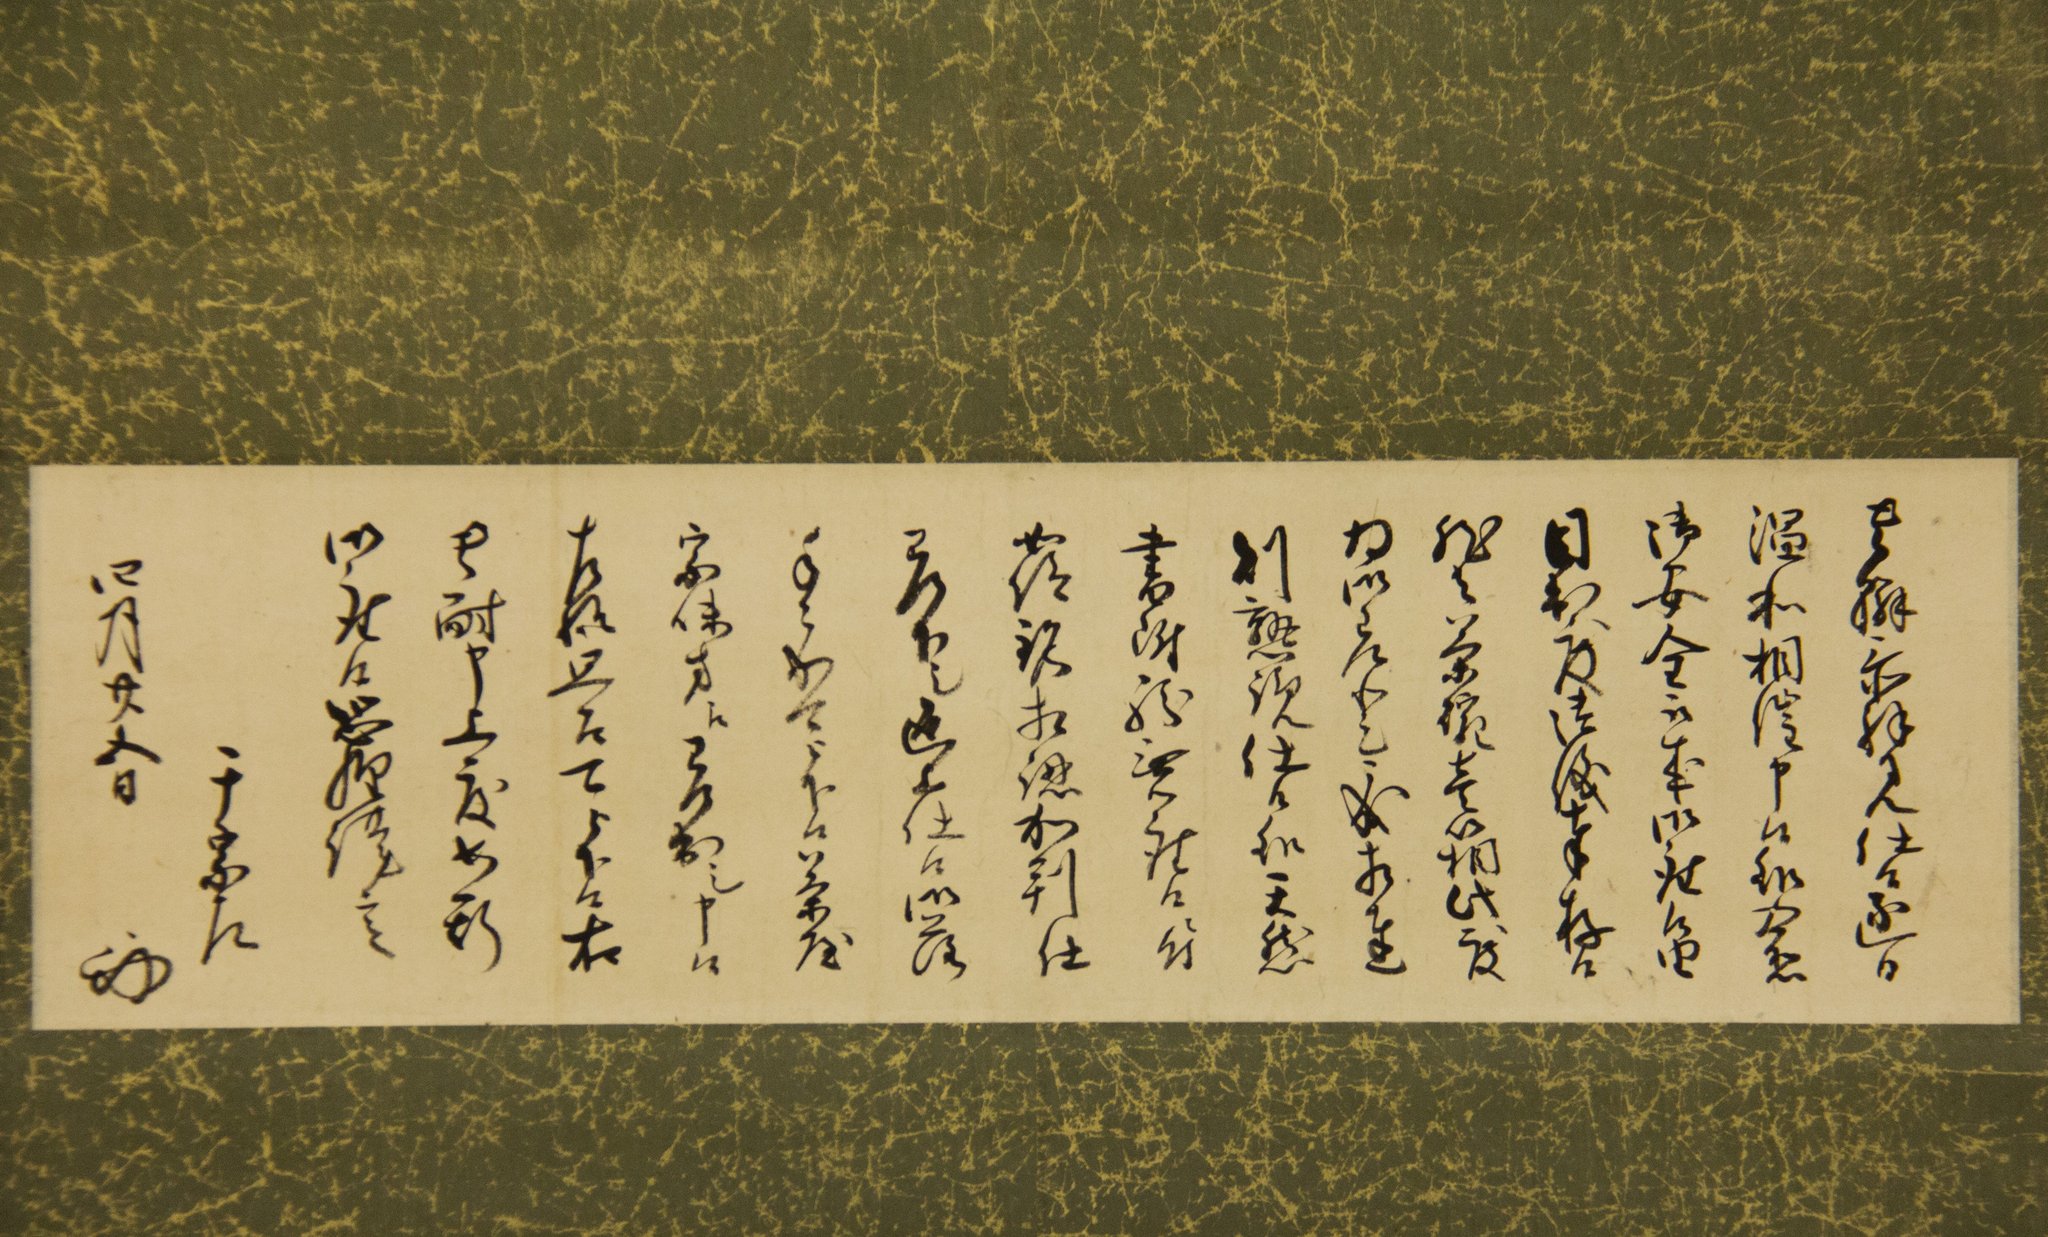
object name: hanging scroll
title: Certificate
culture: japanese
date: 1601-1633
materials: ink, paper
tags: documents